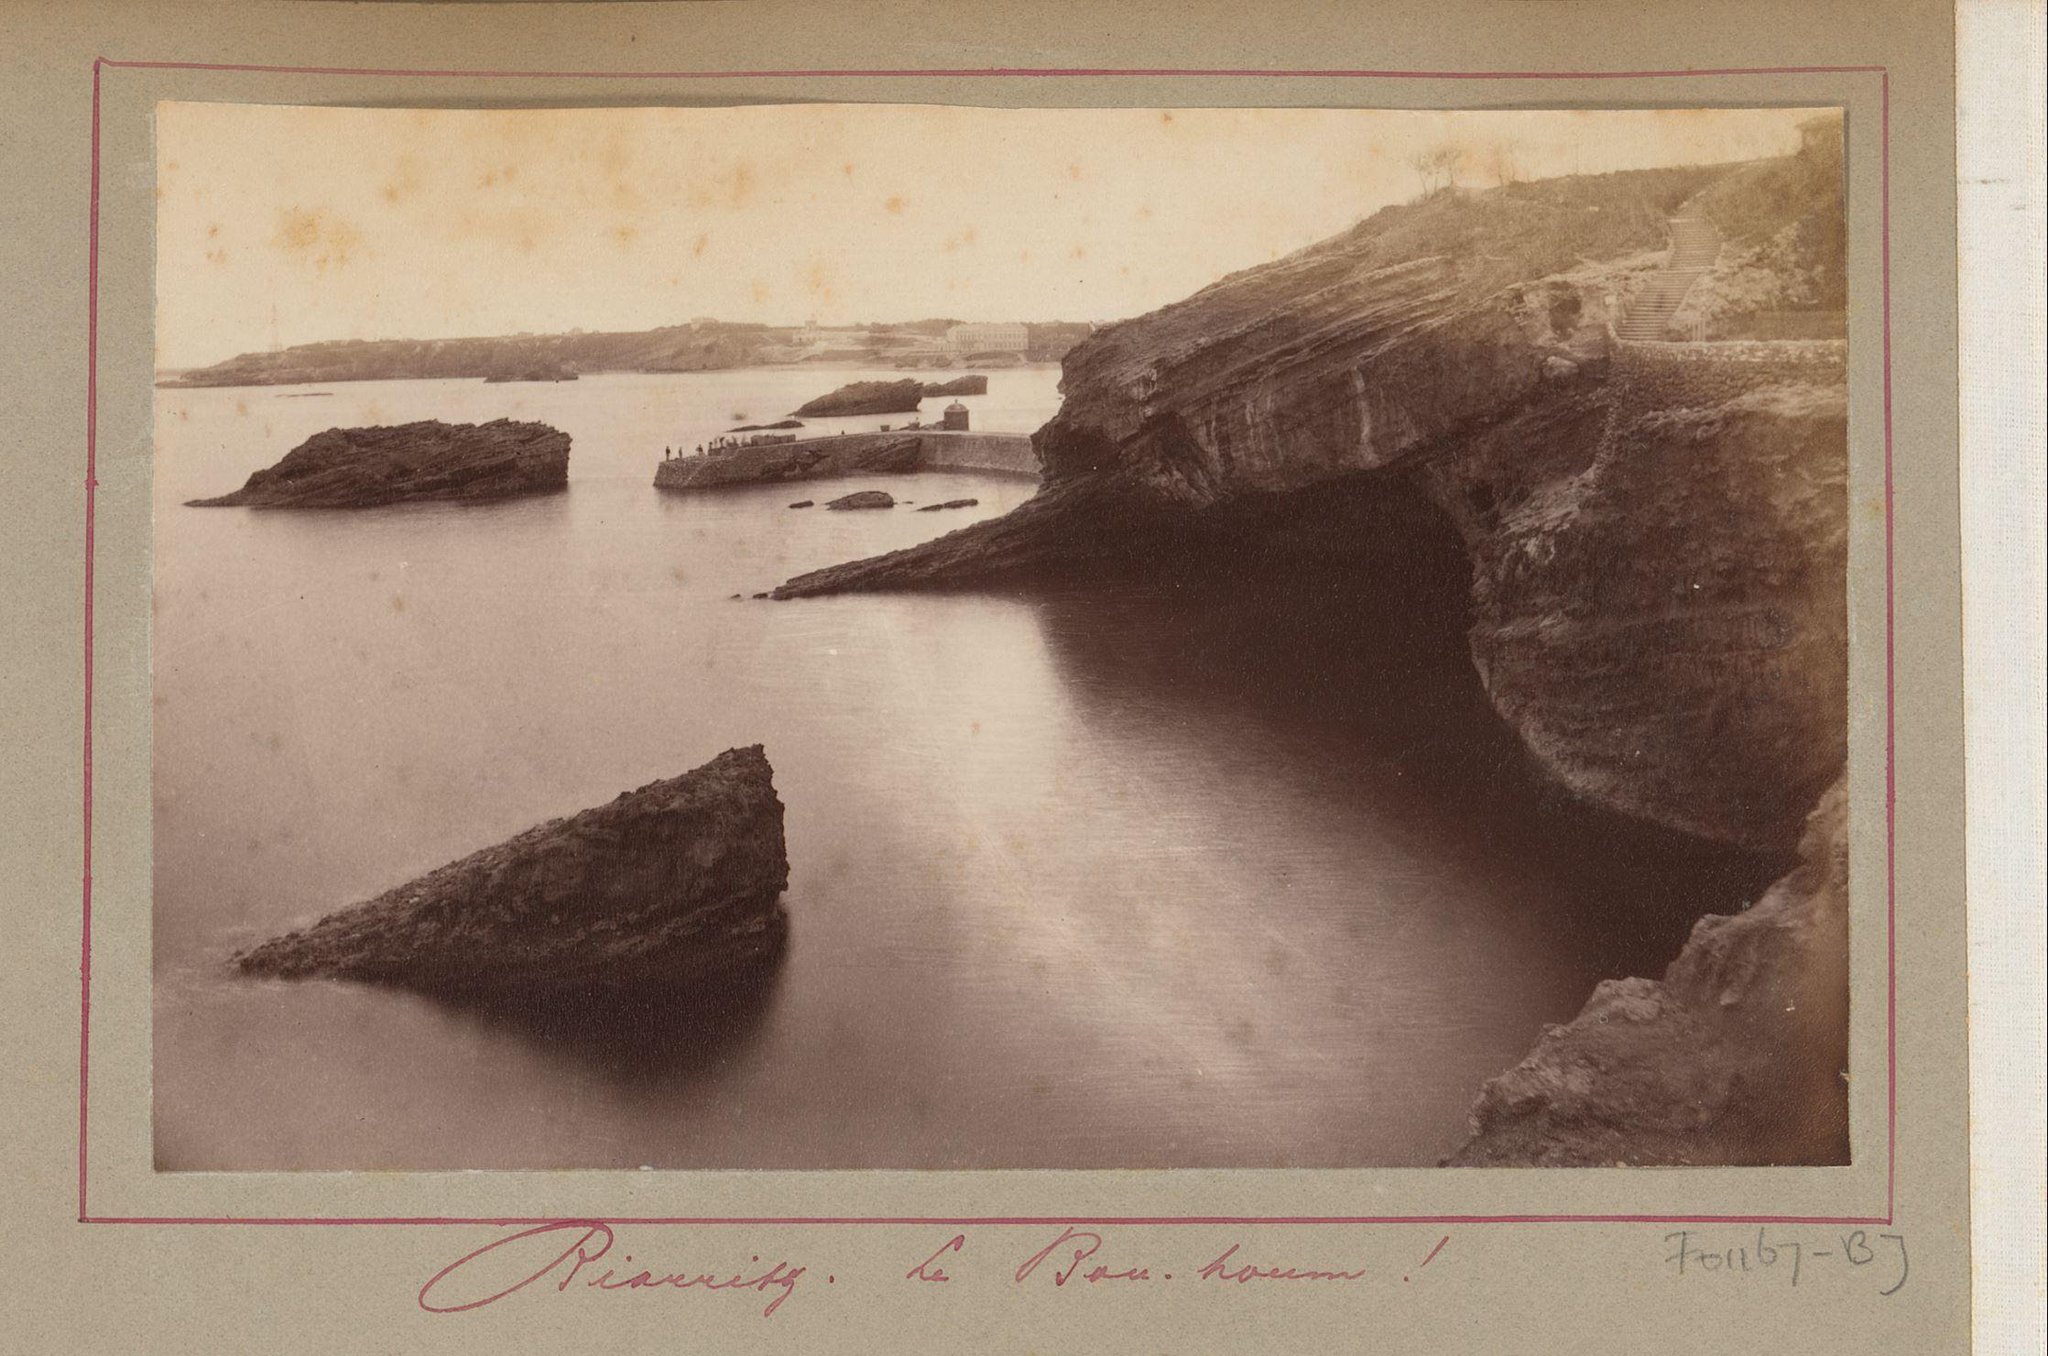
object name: album leaf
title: Rotsen aan de kust van Biarritz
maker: Anonymous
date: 1880-1910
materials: photographic support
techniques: albumen print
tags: rocky coast, sea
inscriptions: annotation: ‘Biarritz; [...]’